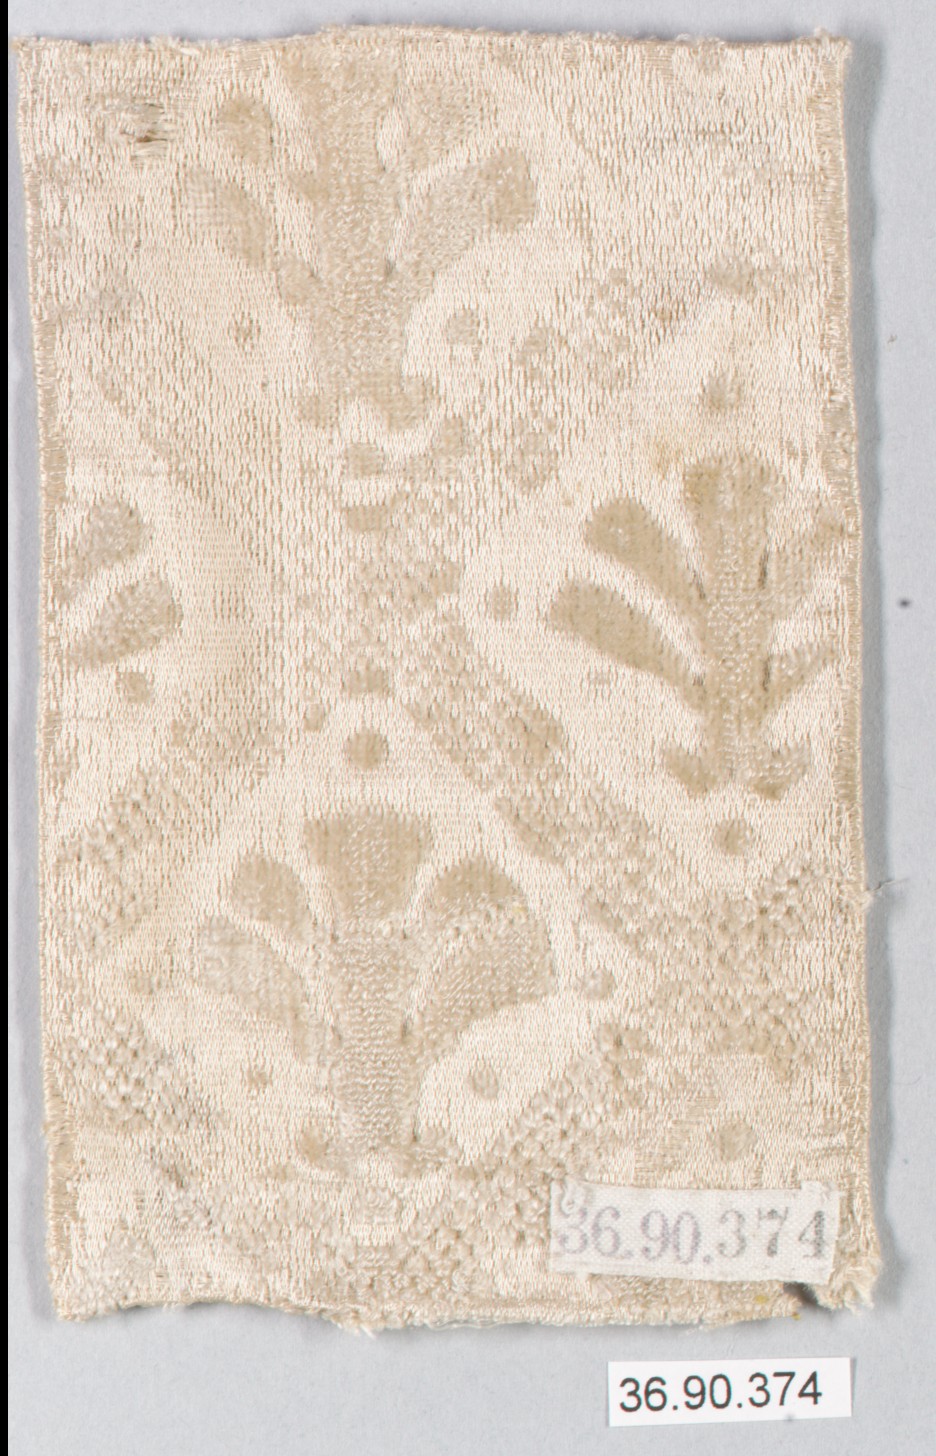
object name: piece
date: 1501-1700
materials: silk